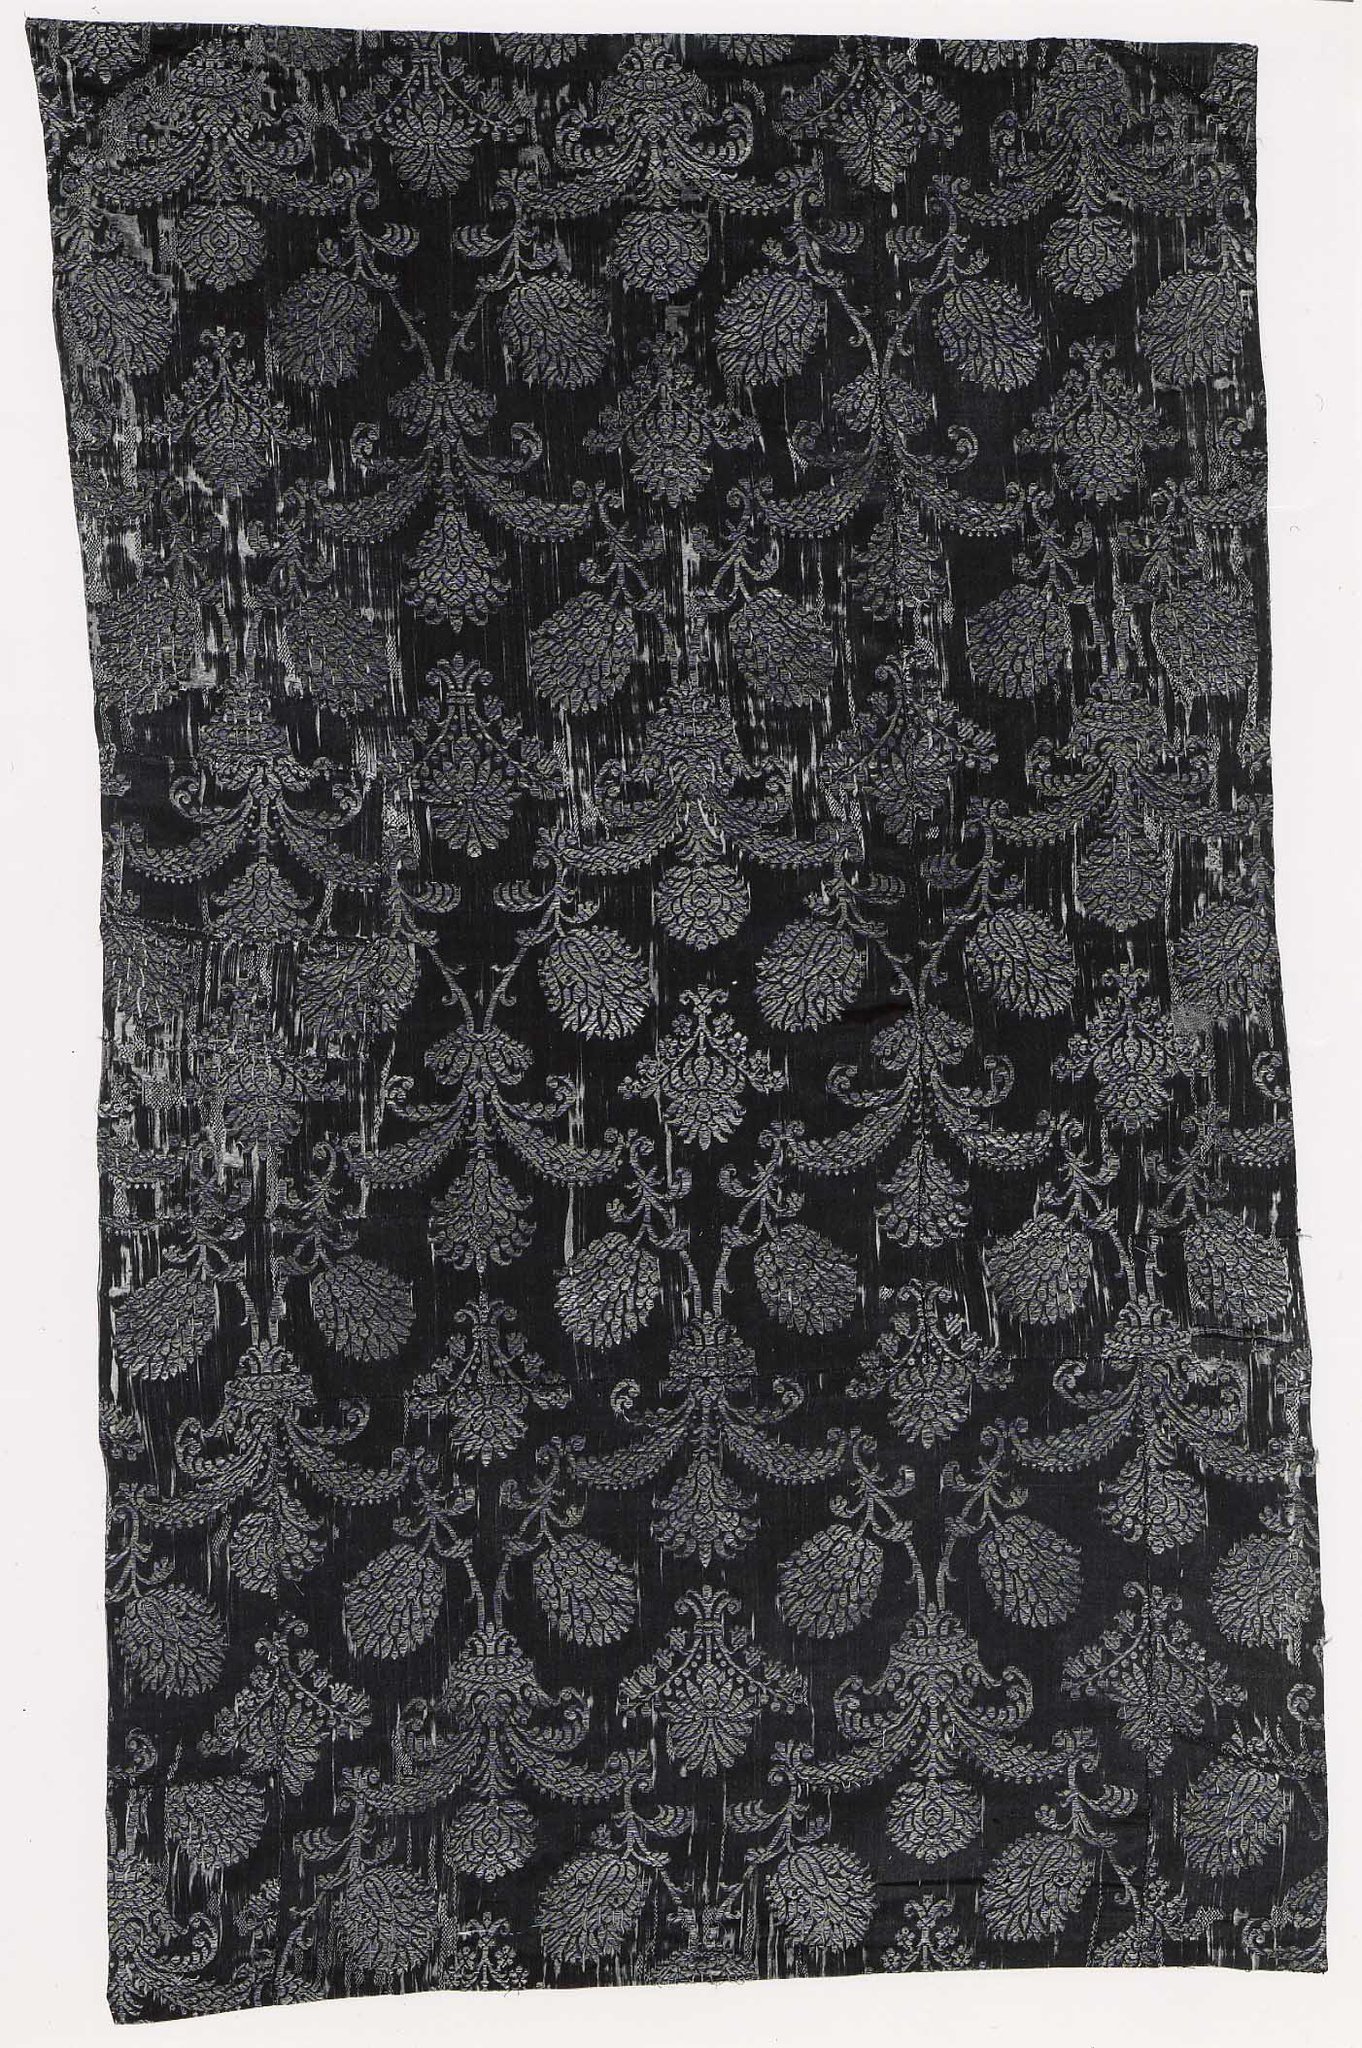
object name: textile piece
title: Piece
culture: italian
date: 1651-1700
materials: cotton, metal, silk